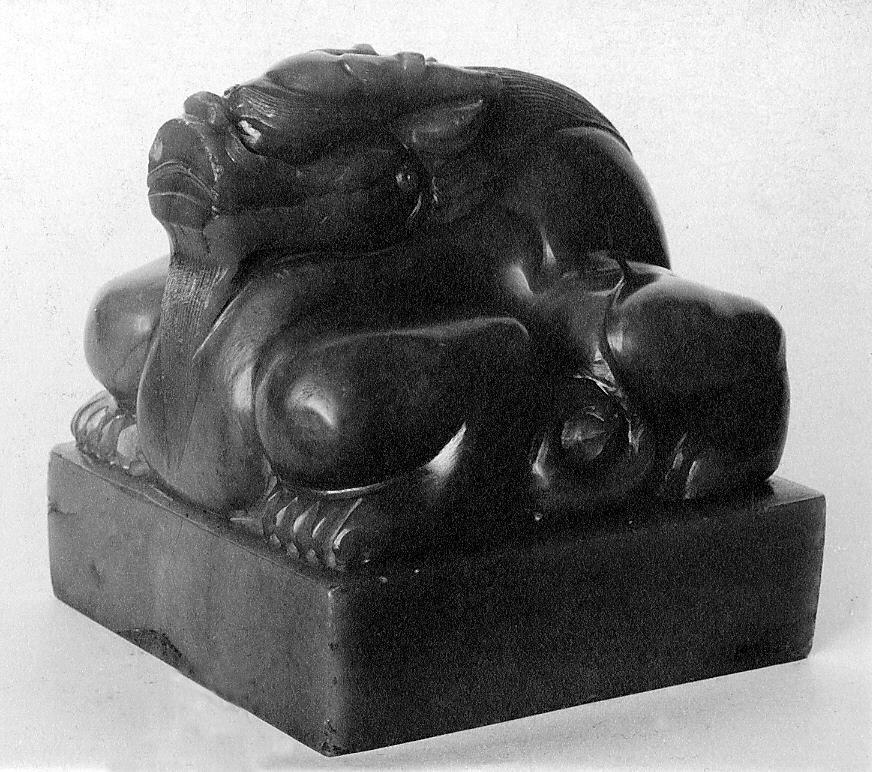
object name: seal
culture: chinese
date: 960-1279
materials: jade